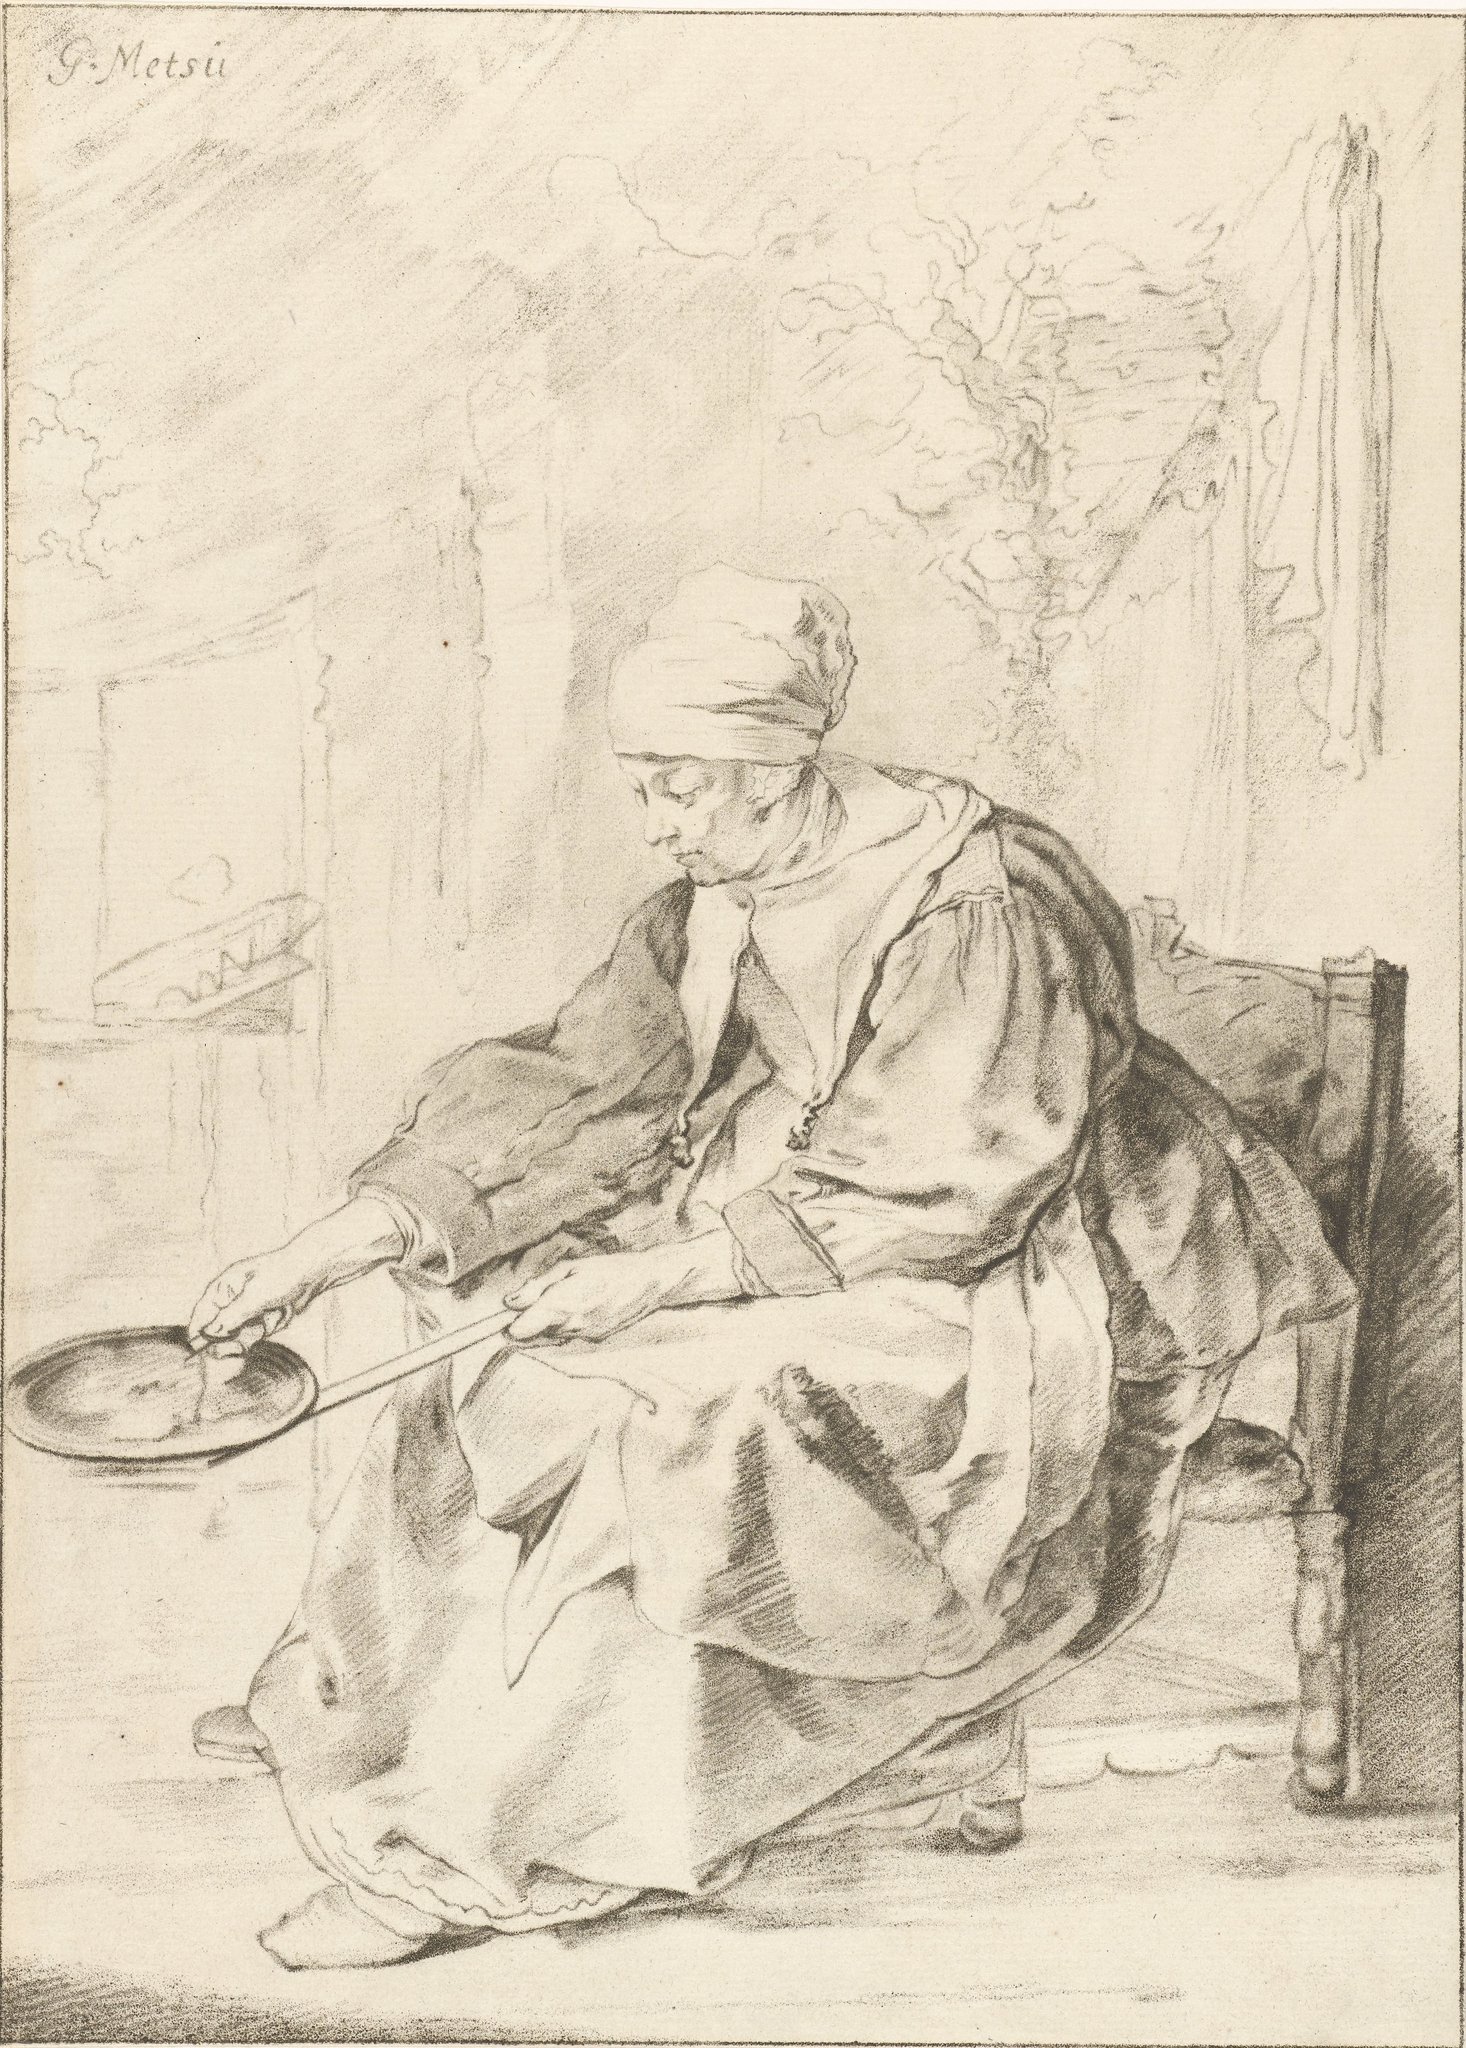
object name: print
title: Pannenkoekenbakster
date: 1768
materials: paper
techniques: printmaking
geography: amsterdam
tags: pancakes, adult woman, cooking food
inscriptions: inscription: ‘Deeze, onvoltooyde Prent als een Proef - geschonken aan mijne Waarde neef DWEdG J v Dussen PvA / G. Metsu f del Ploos van Amste; Fecit 1768’, collector's mark: Lugt 240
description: Een vrouw, zittend op een stoel bij een oven, met een koekenpan in haar hand.